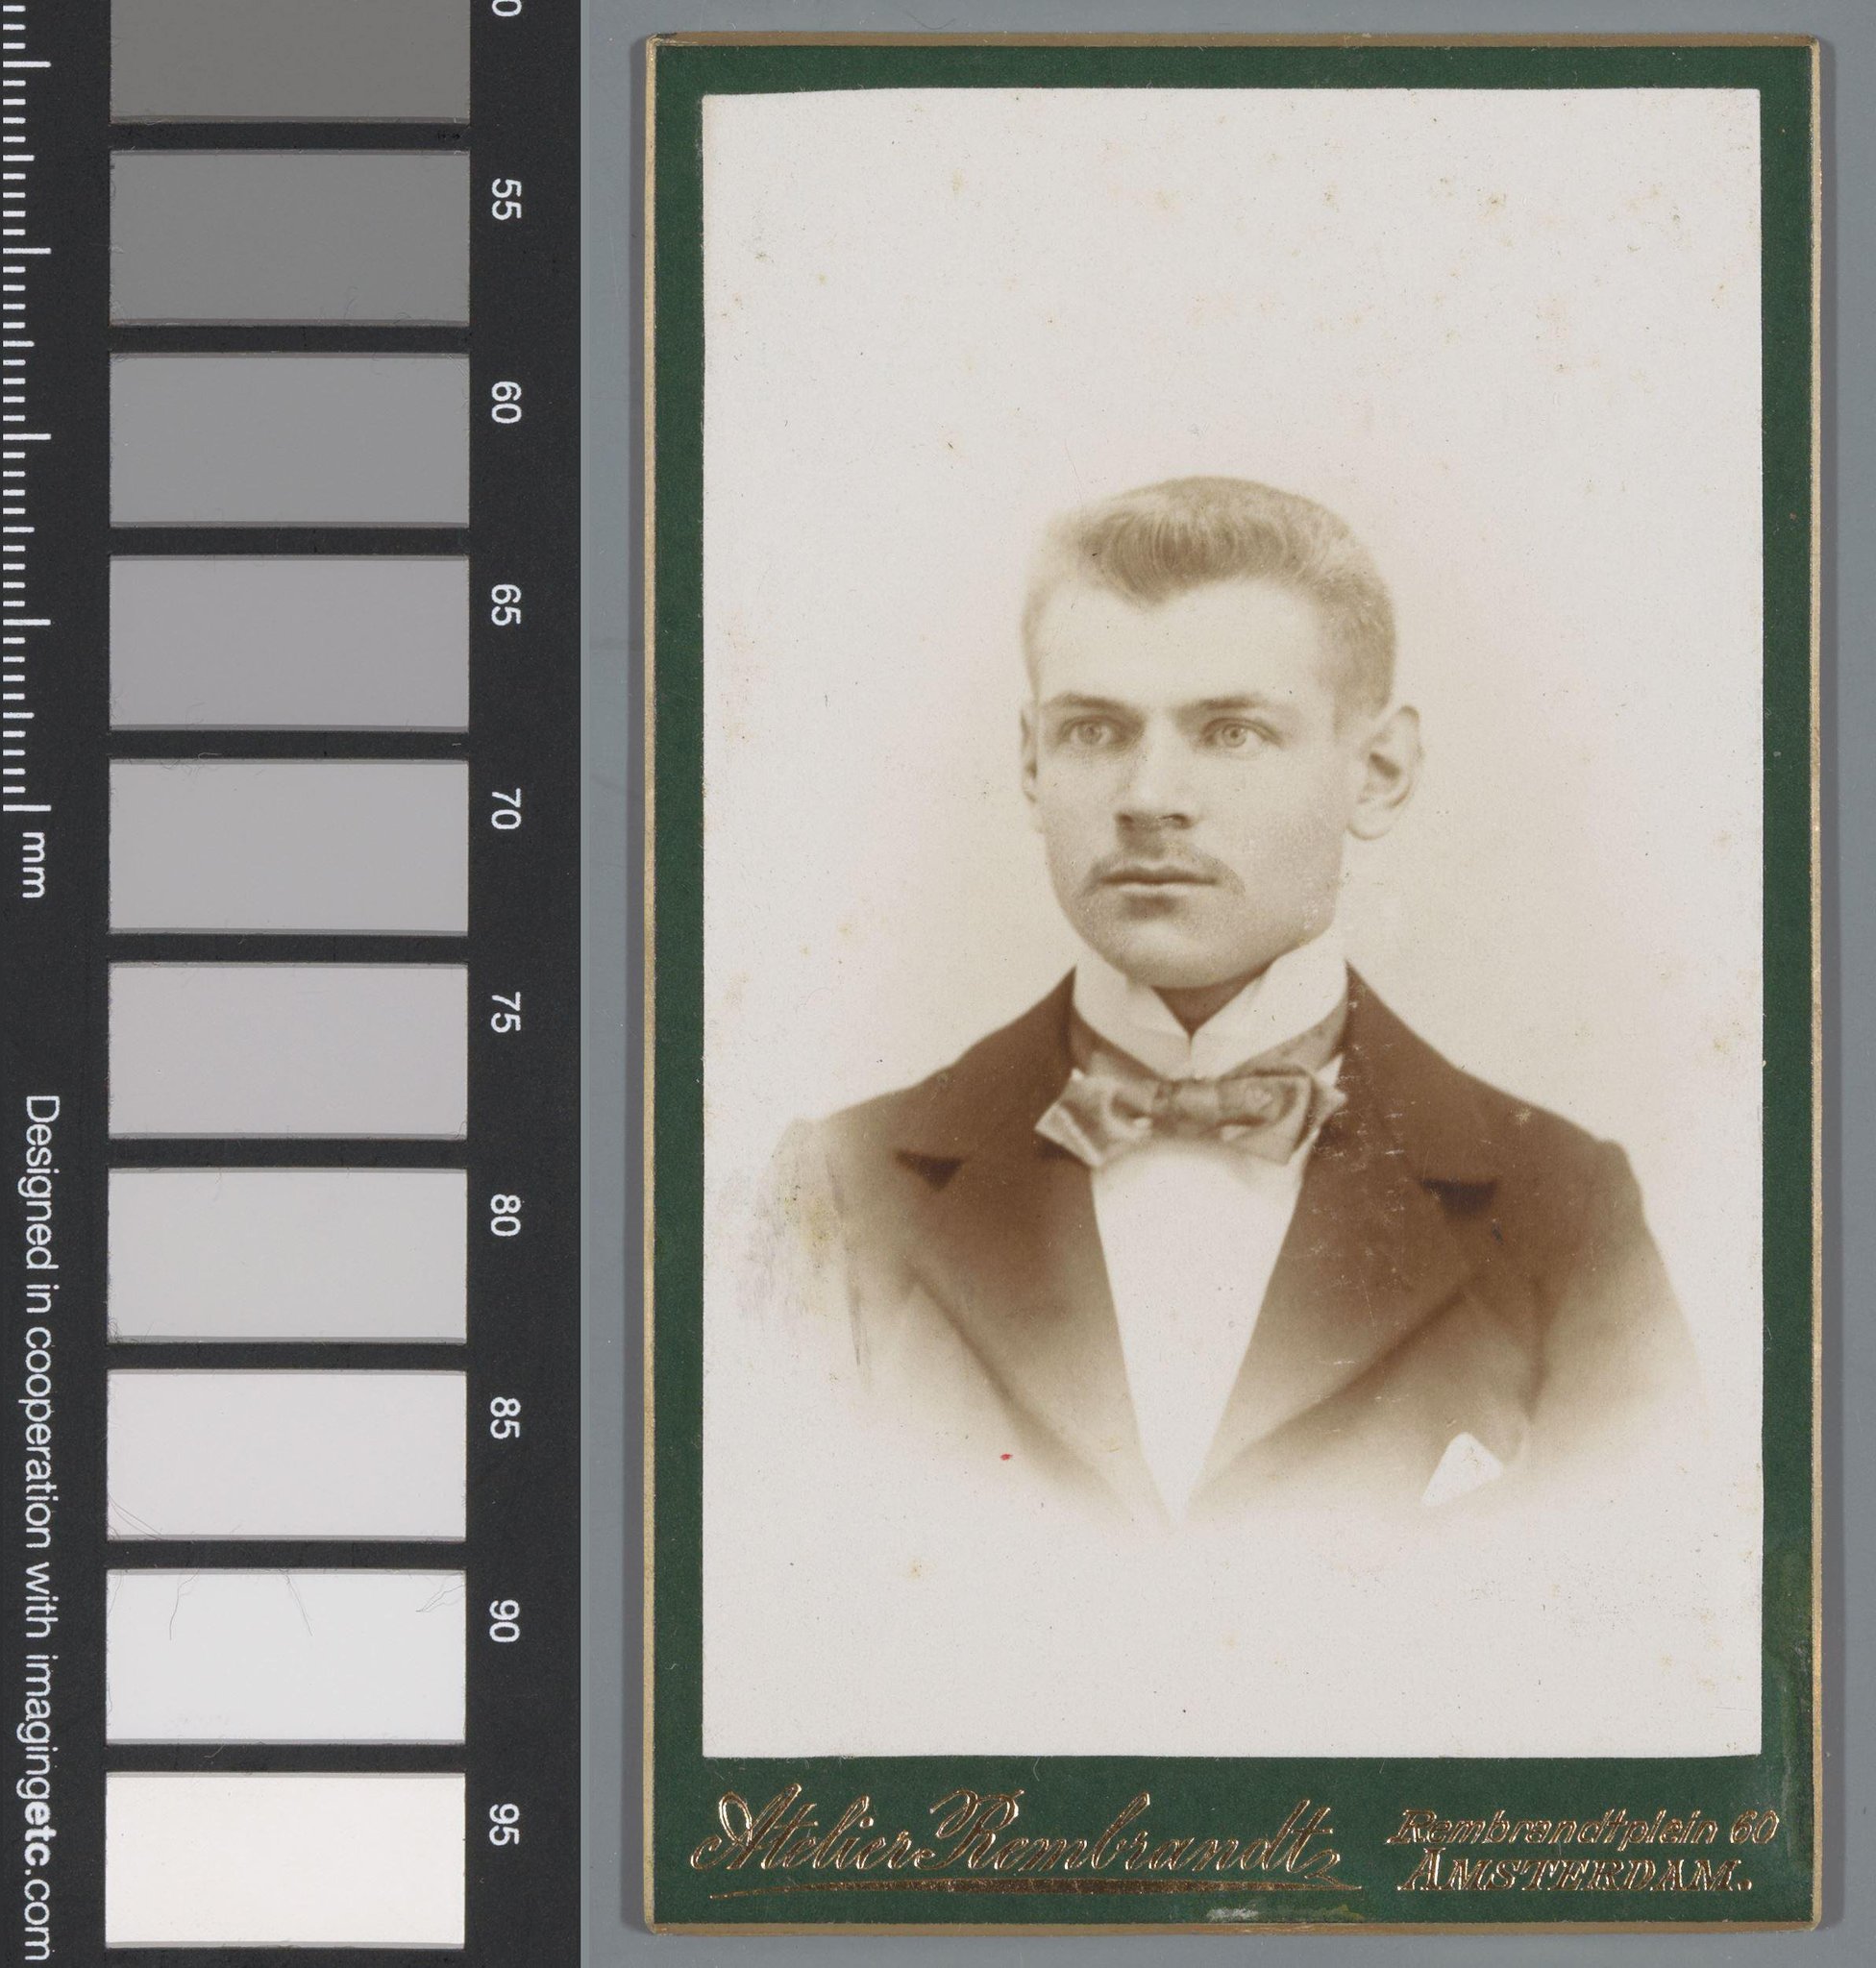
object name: carte de visite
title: Portret van een onbekende man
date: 1880-1911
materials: cardboard, photographic support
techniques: collodion silver print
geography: amsterdam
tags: adult man, historical persons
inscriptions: inscription: ‘No............/ PHOTOGRAPHIE/ ARTISTIQUE/ Rembrandt/ AMSTERDAM/ Rembrandtplein 60./ Specialiteit in vergrootingen/ tot levensgroot./ DE PLAAT BLIJFT TER NABESTELLING BEWAARD./ TRAPP & MÜNCH, BERLIN.’